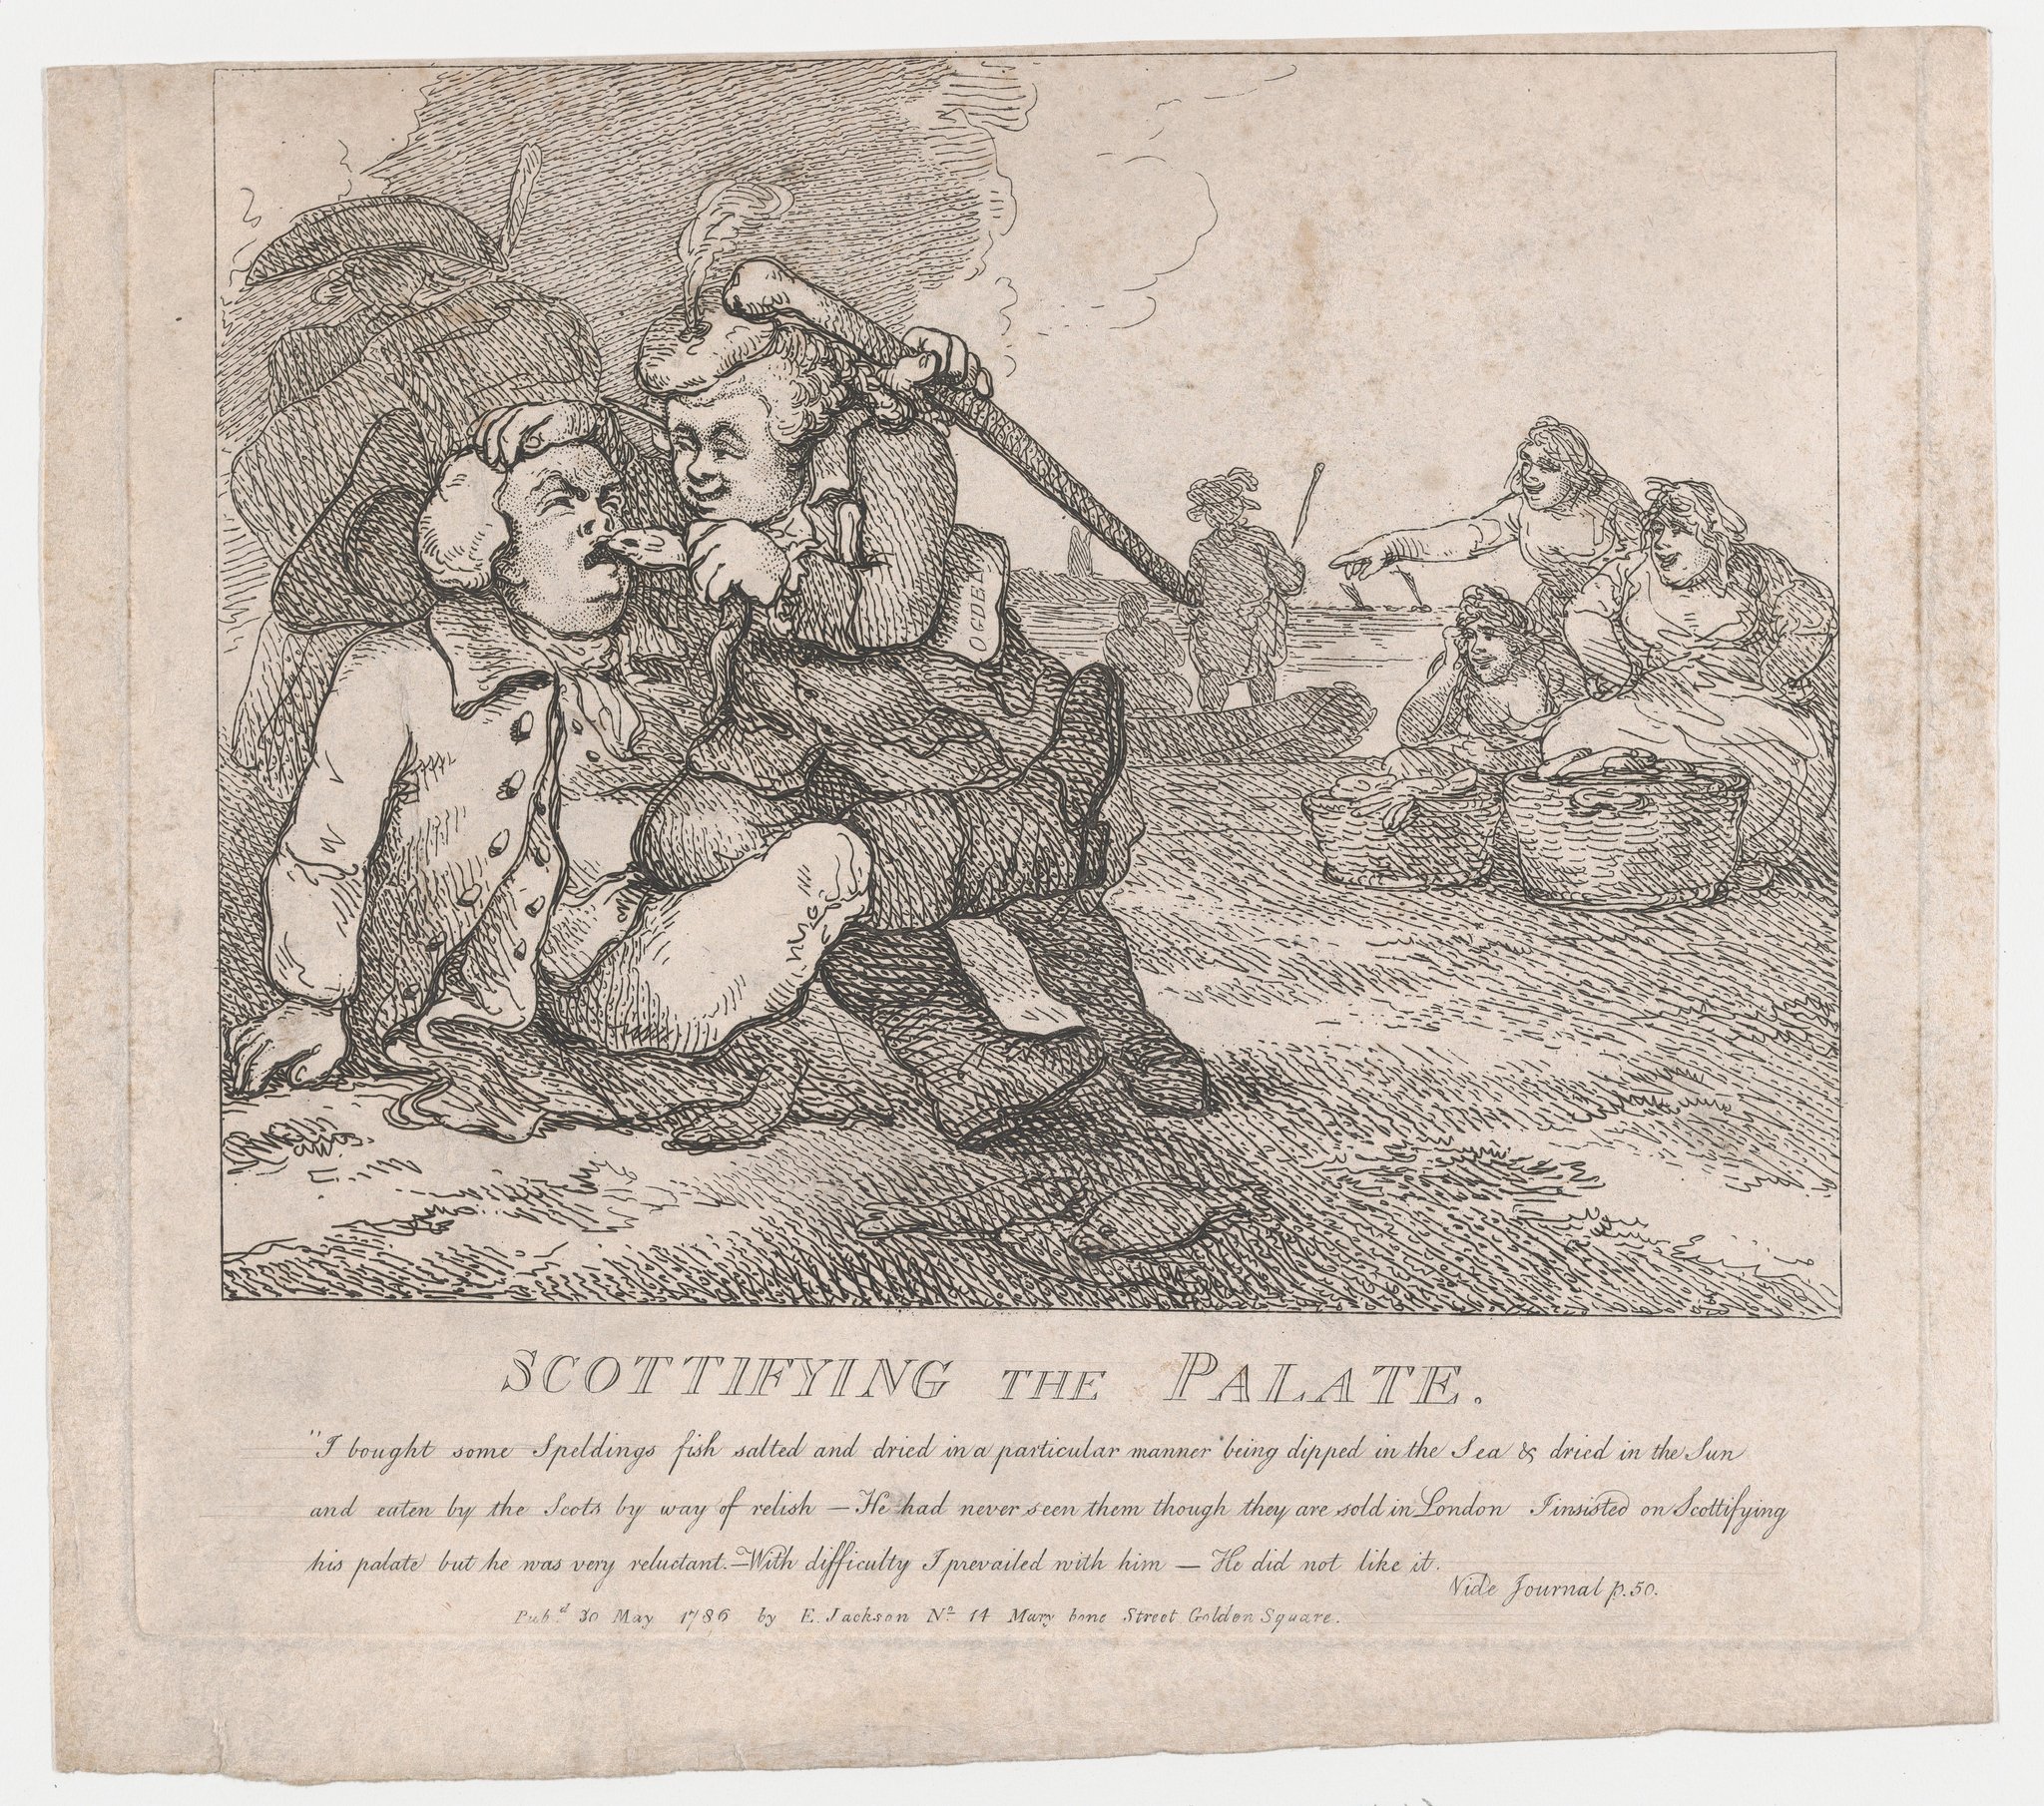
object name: print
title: Scottifying the Palate (Picturesque Beauties of Boswell, Part the First)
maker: thomas rowlandson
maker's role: artist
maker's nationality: british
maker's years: 1757-1827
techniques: etching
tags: satire,men,women